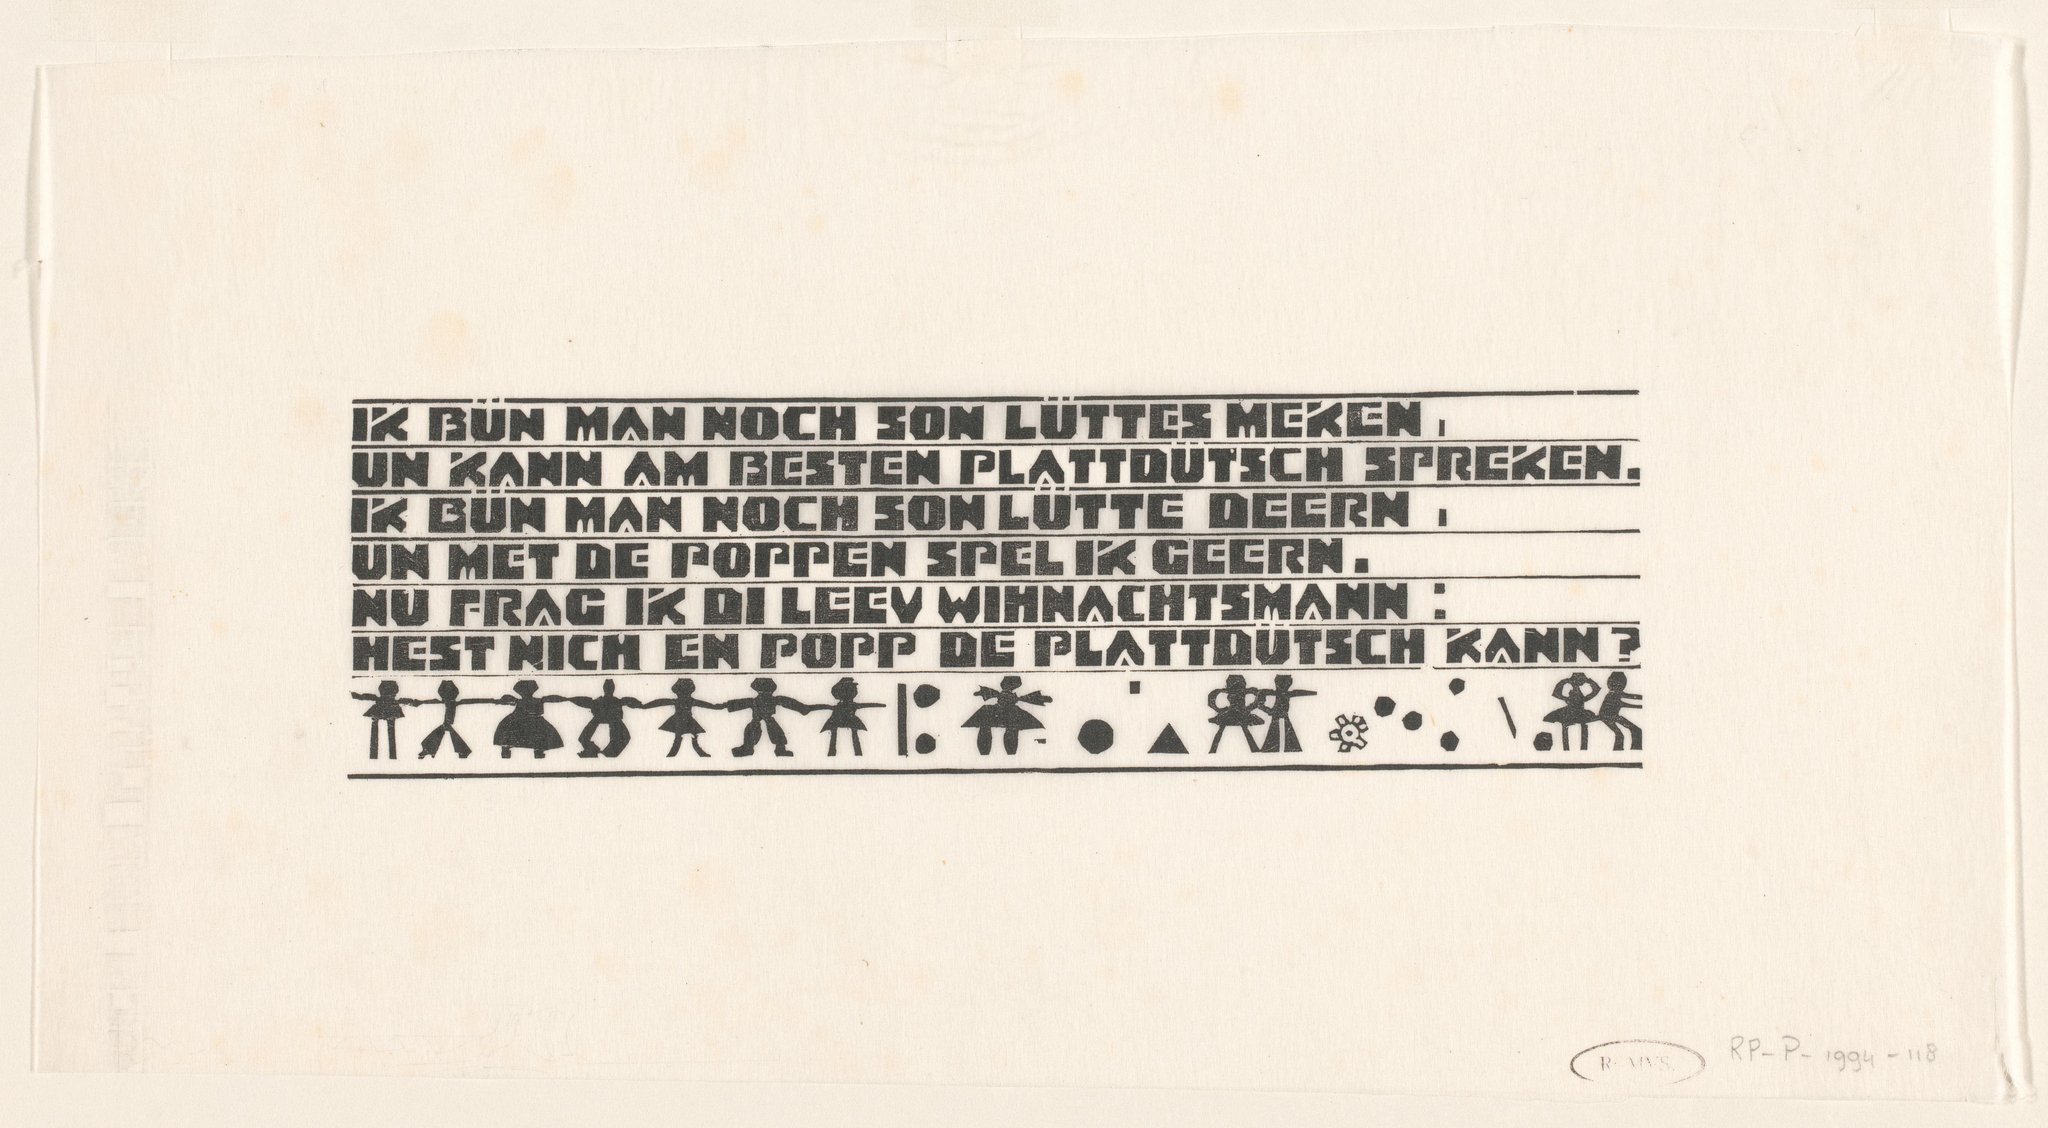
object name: print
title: Duits kinderlied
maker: reijer stolk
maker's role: draughtsman, print maker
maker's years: 1896-1945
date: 1906-1945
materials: paper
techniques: woodcut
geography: netherlands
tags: row dancing (children's games)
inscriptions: collector's mark: Lugt 2228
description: Tekst van een Duits vers: "Ik bün Man noch son Lüttes meken (...) hest nich en Popp de Platdütsch kann?" met daaronder een rij dansende kinderen.